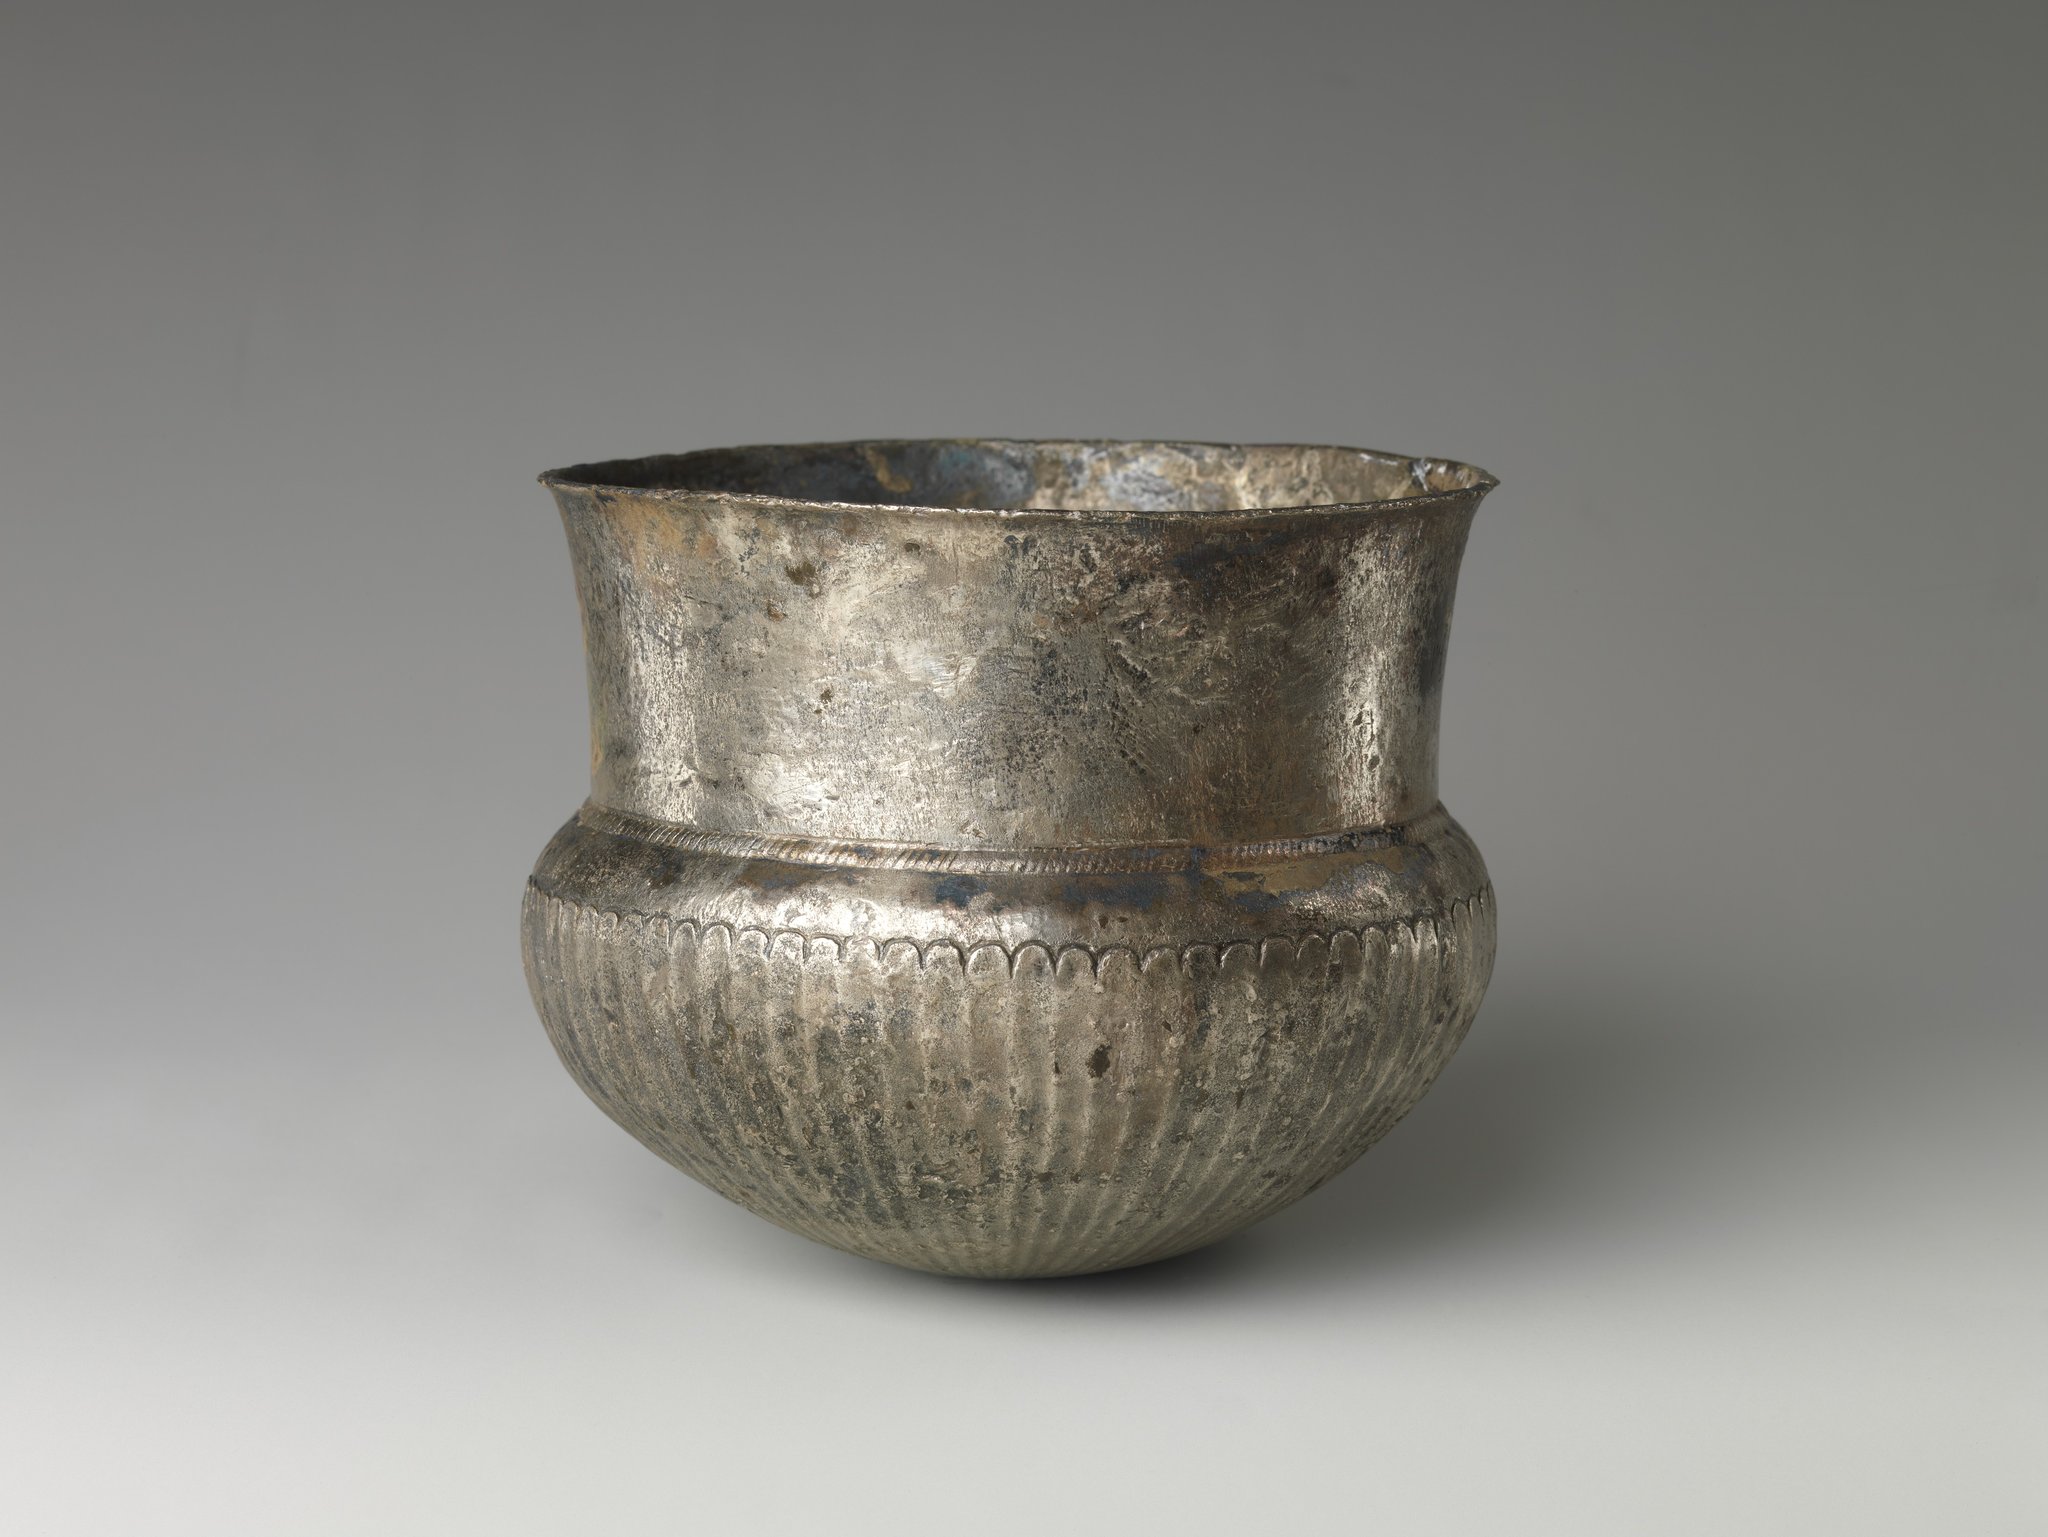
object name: bowl, fluted, weight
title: Bowl with flutes from shoulder to rosette at base and with inscribed weight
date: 400-301 BCE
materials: silver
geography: egypt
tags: flutes